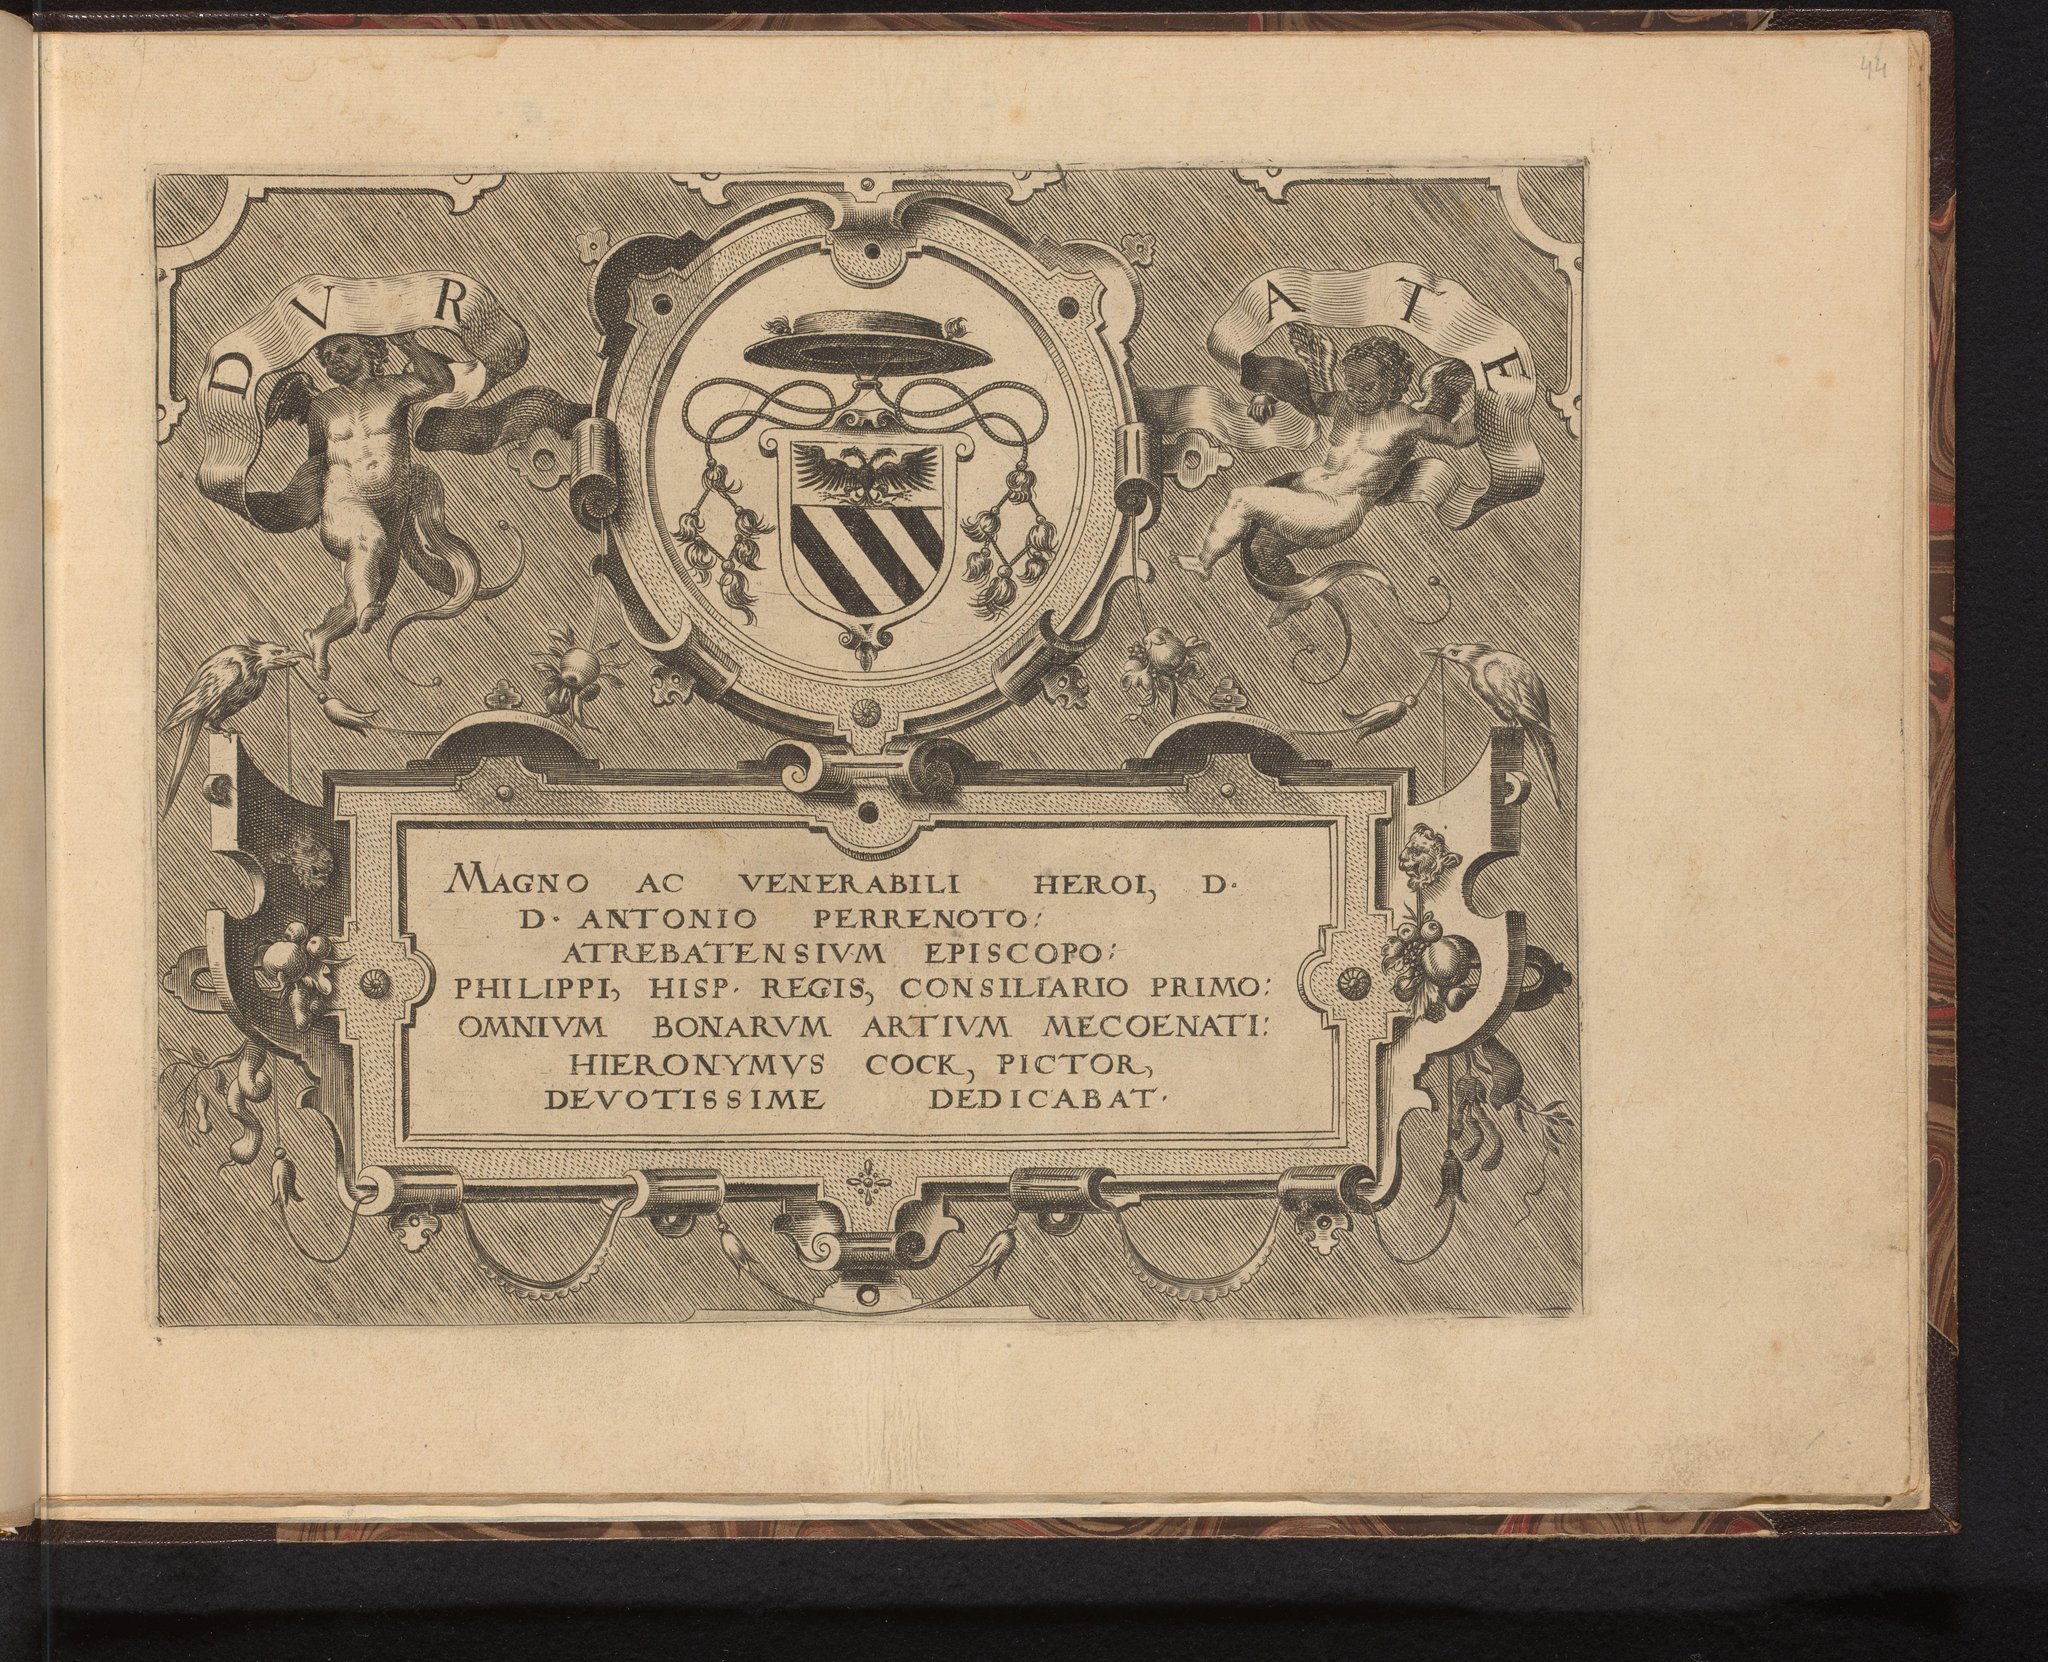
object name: album leaf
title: Architectura de Oorden Tusschana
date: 1560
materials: paper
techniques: etching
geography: antwerp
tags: scrollwork, strapwork ~ ornament, ornament ~ cartouche, cupids: 'amores', 'amoretti', 'putti', armorial bearing, heraldry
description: Dubbele cartouche met bovenaan het wapen van Antoine Perrenot, kardinaal de Granvelle, geflankeerd door twee putti met een banderol (Dur/ate). Daaronder in een cartouche met een opdracht aan Granvelle, in een omlijsting van rolwerk. De prent maakt deel uit van een album.